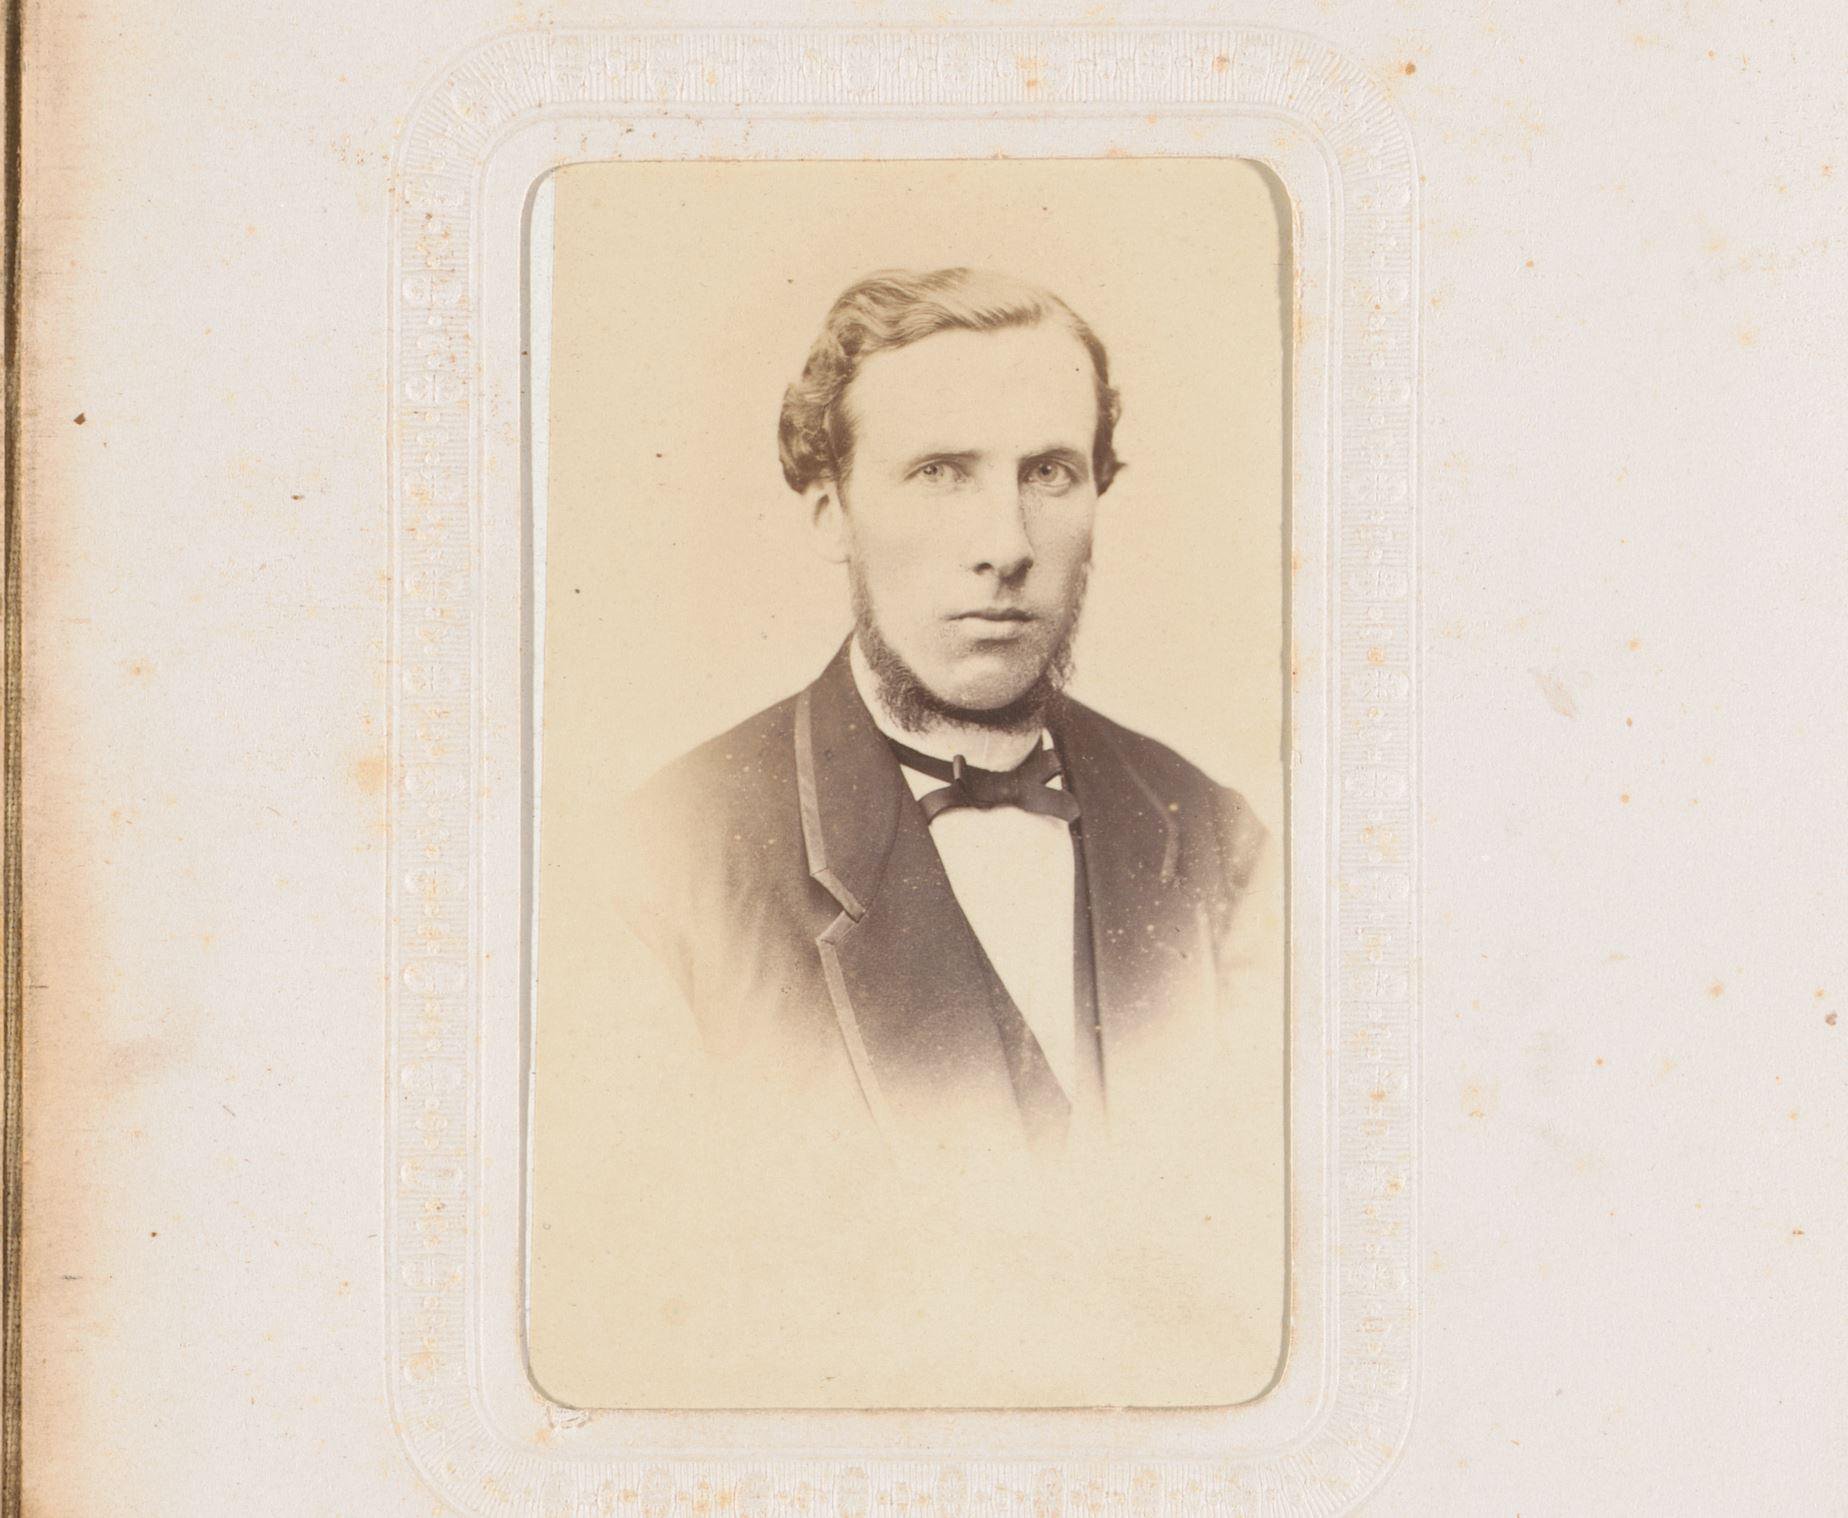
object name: carte de visite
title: Portret van een man met ringbaard en vlinderstrik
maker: Anonymous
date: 1860-1900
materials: cardboard, photographic support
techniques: albumen print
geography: netherlands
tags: historical persons, beard